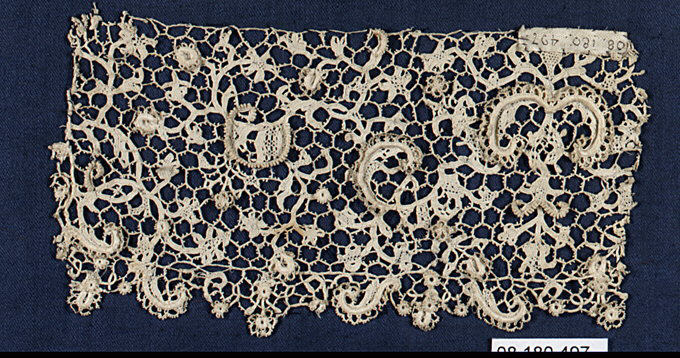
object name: fragment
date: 1601-1700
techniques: lace